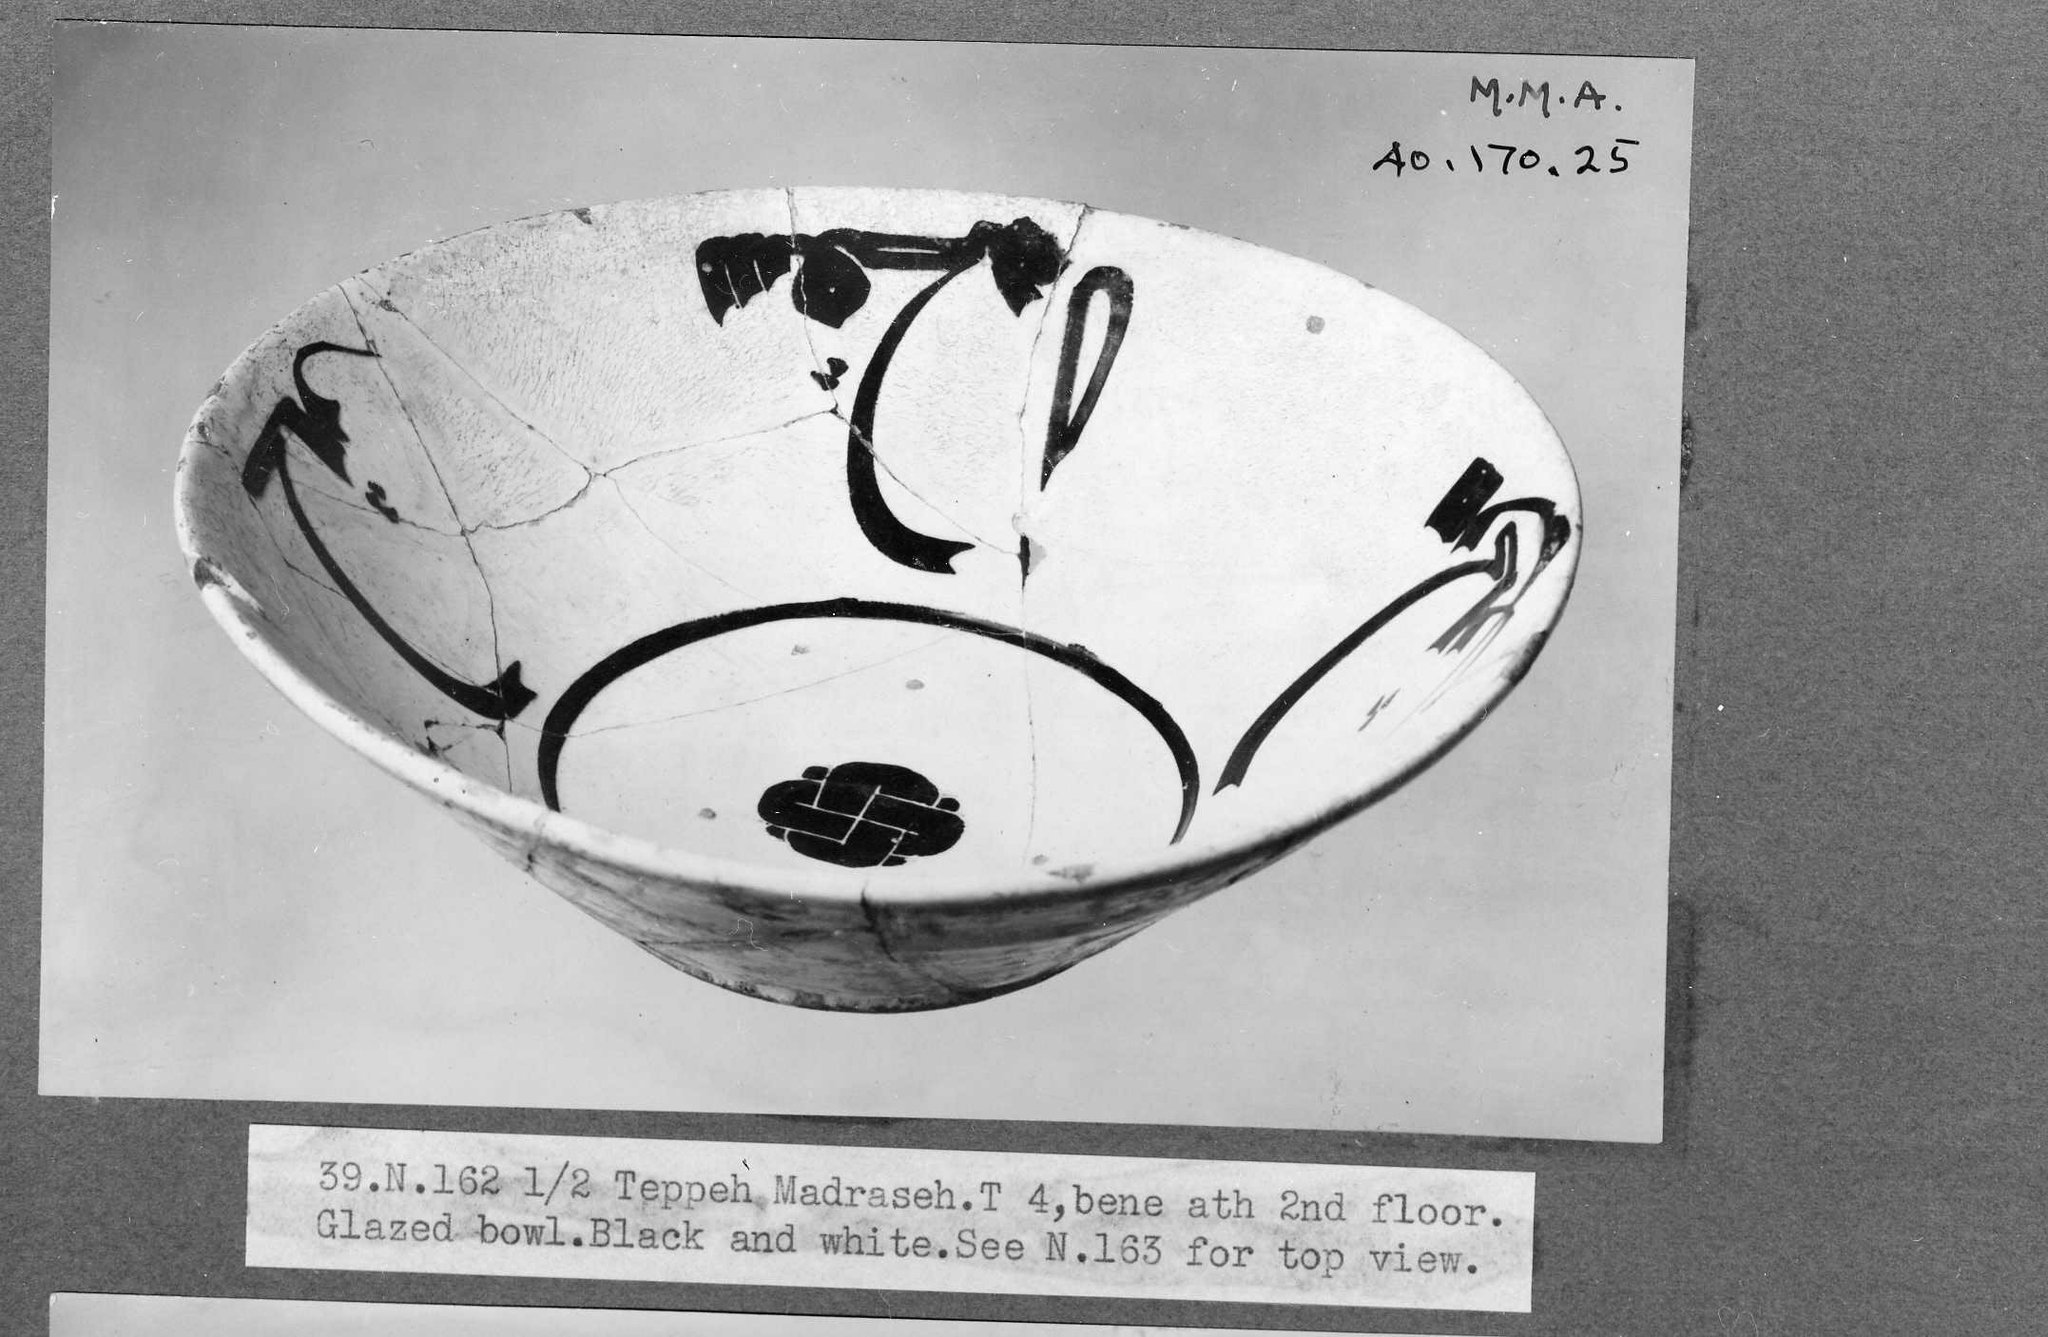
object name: bowl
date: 801-1000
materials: earthenware, glaze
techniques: incising, polychrome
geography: iran